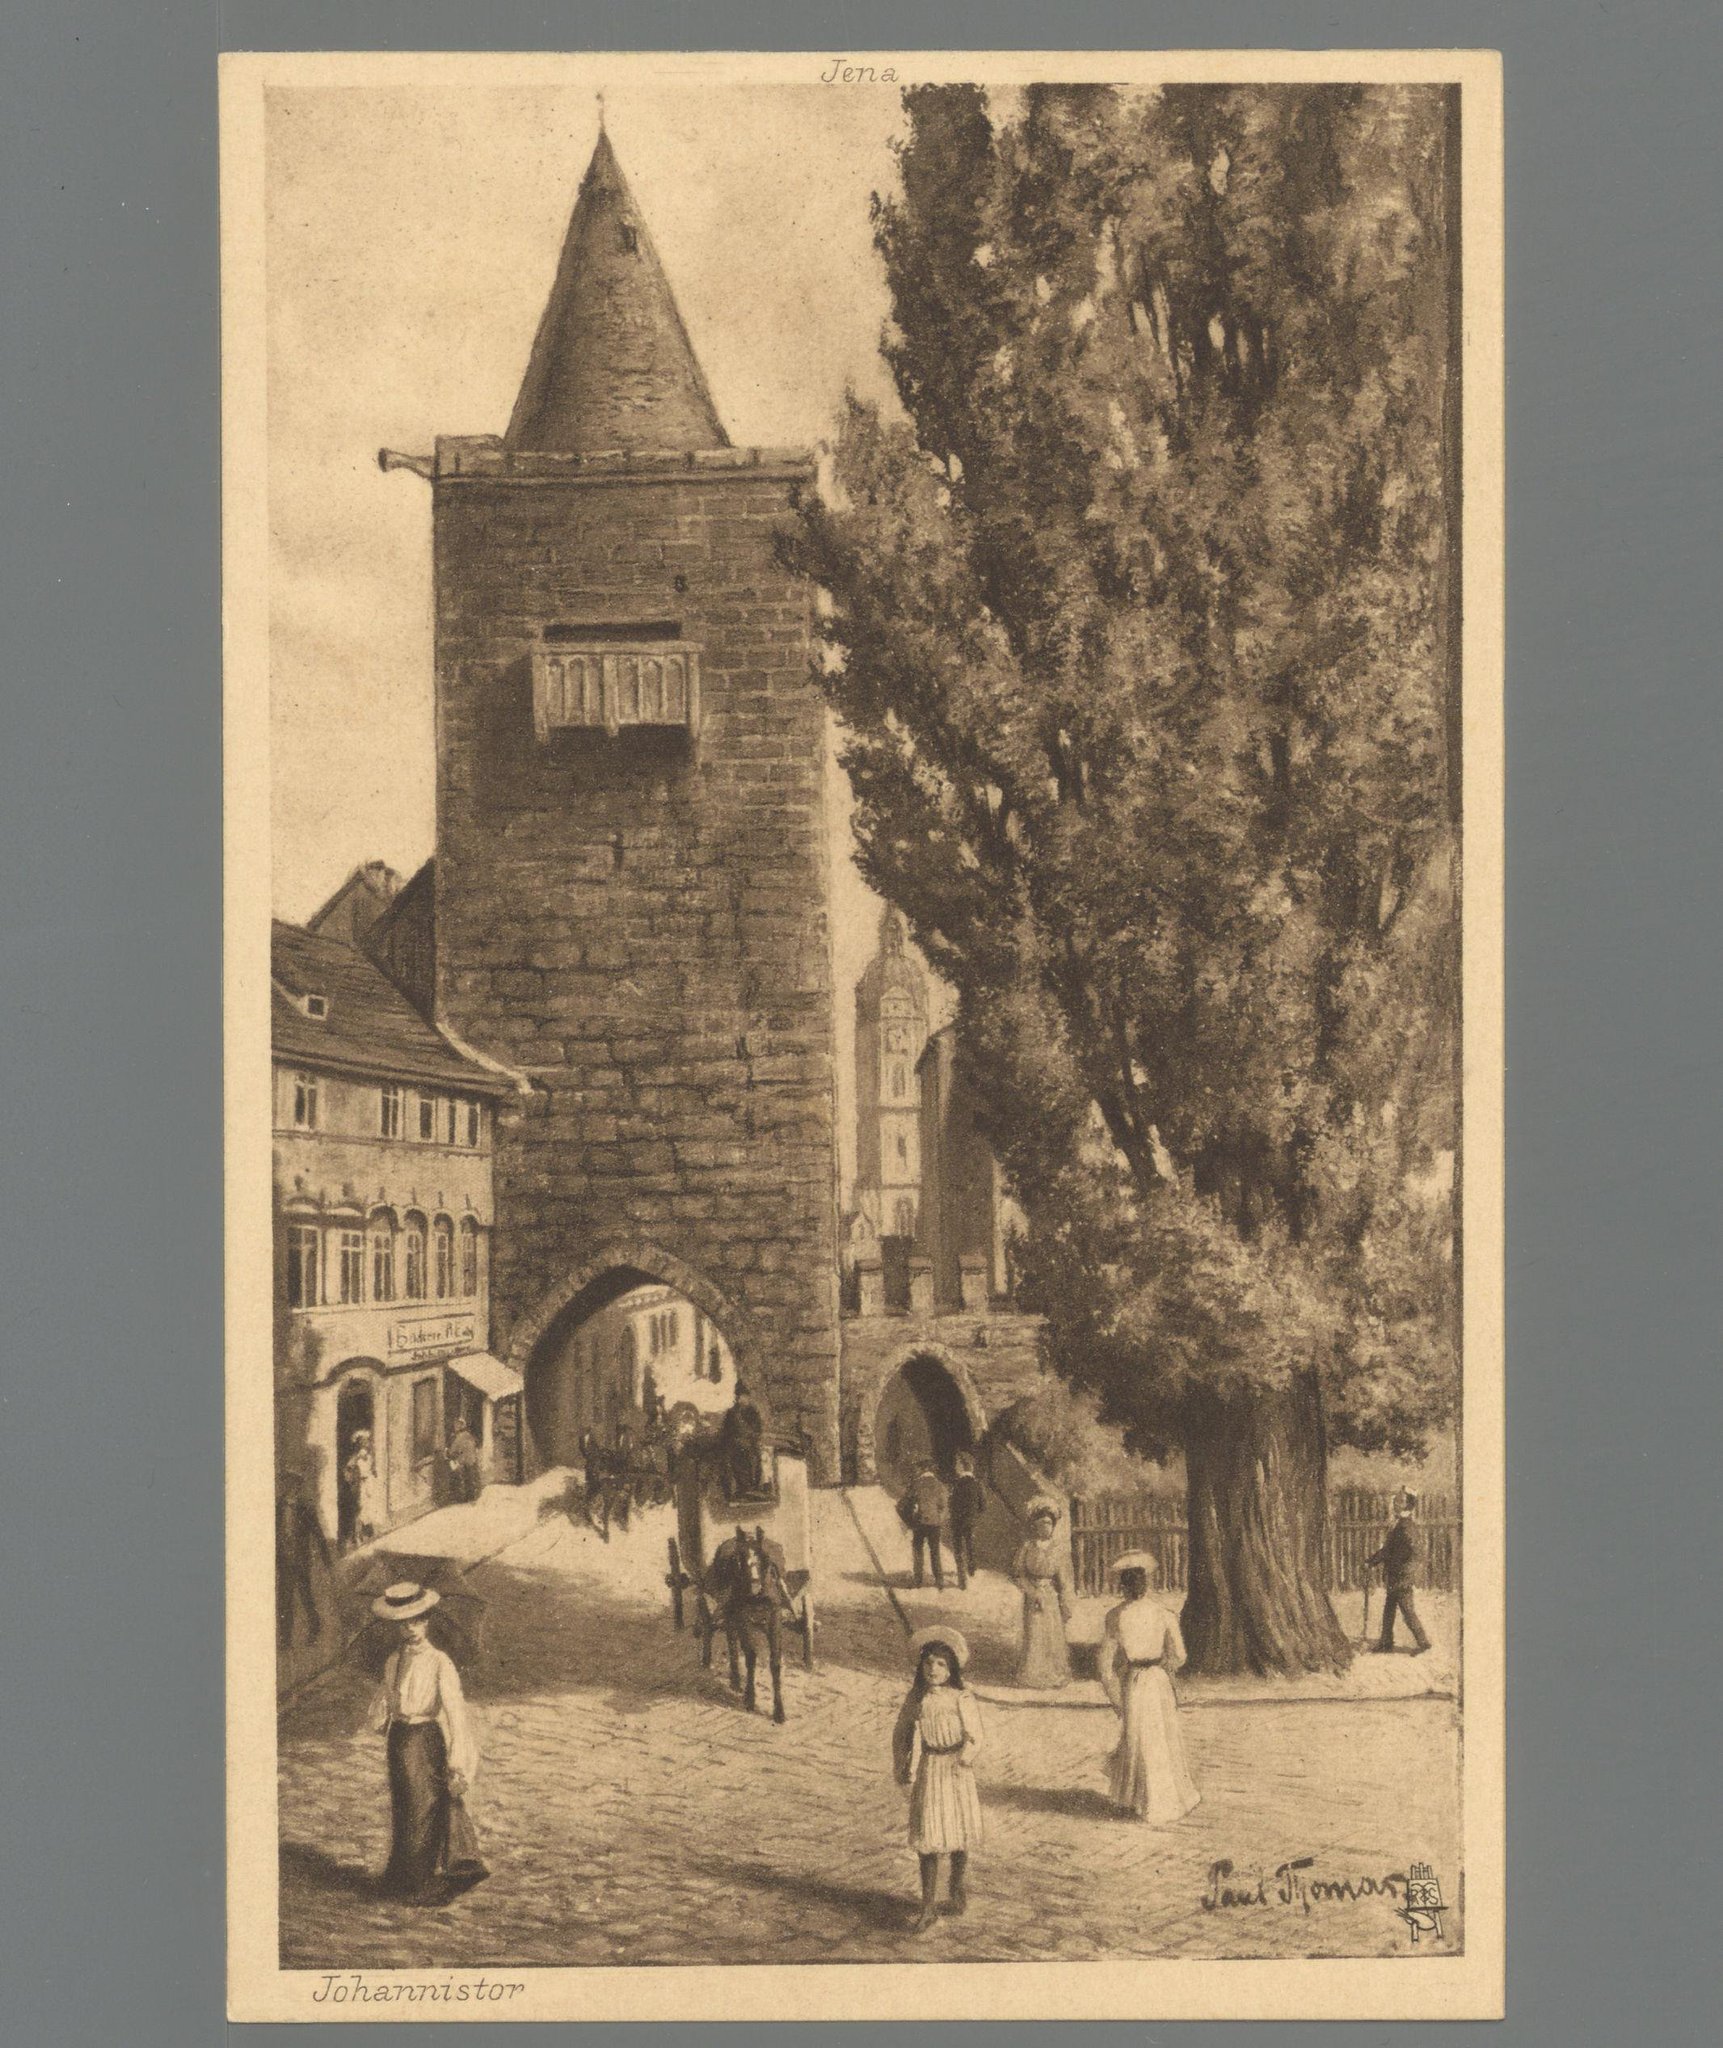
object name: reproduction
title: Jena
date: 1908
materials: cardboard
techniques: rotogravure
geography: berlin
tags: city-view, and landscape with man-made constructions, church (exterior), city-gate